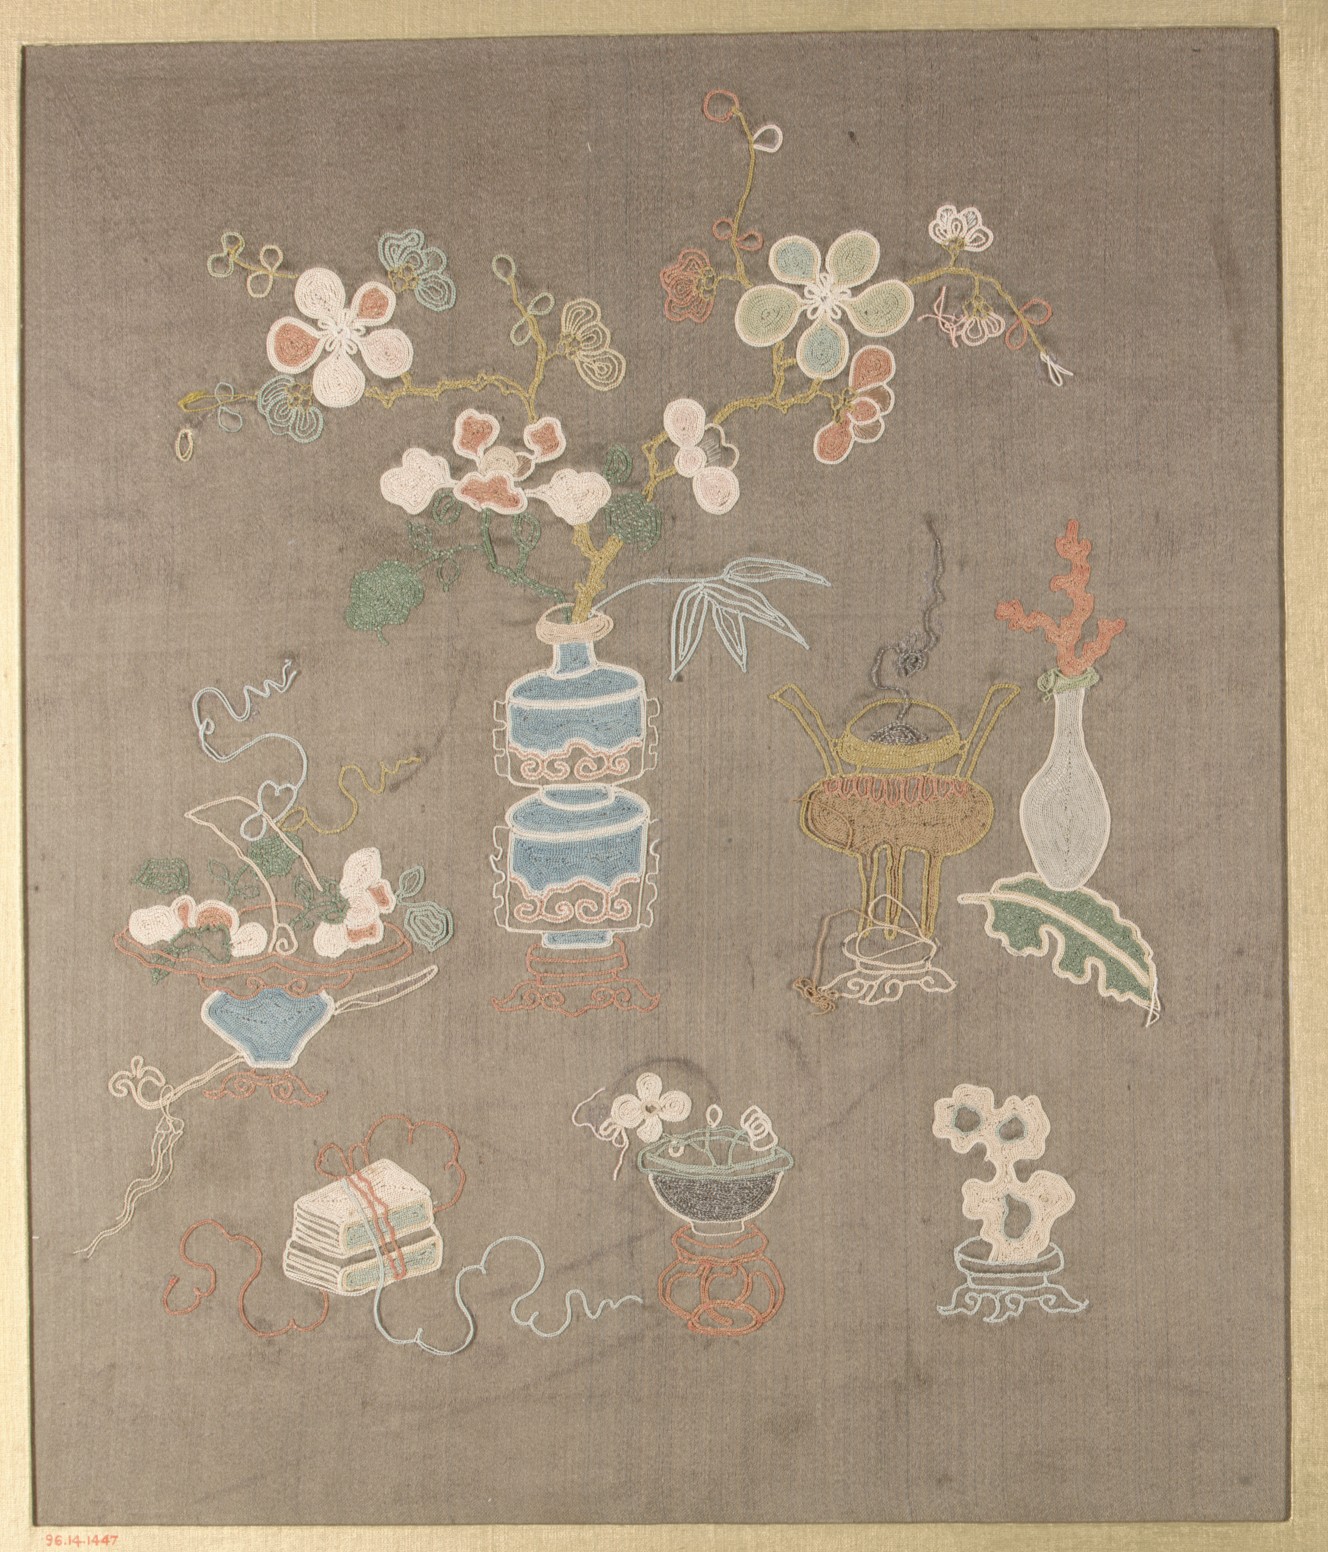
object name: piece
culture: chinese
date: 1701-1900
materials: metal thread, silk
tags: flowers,plants